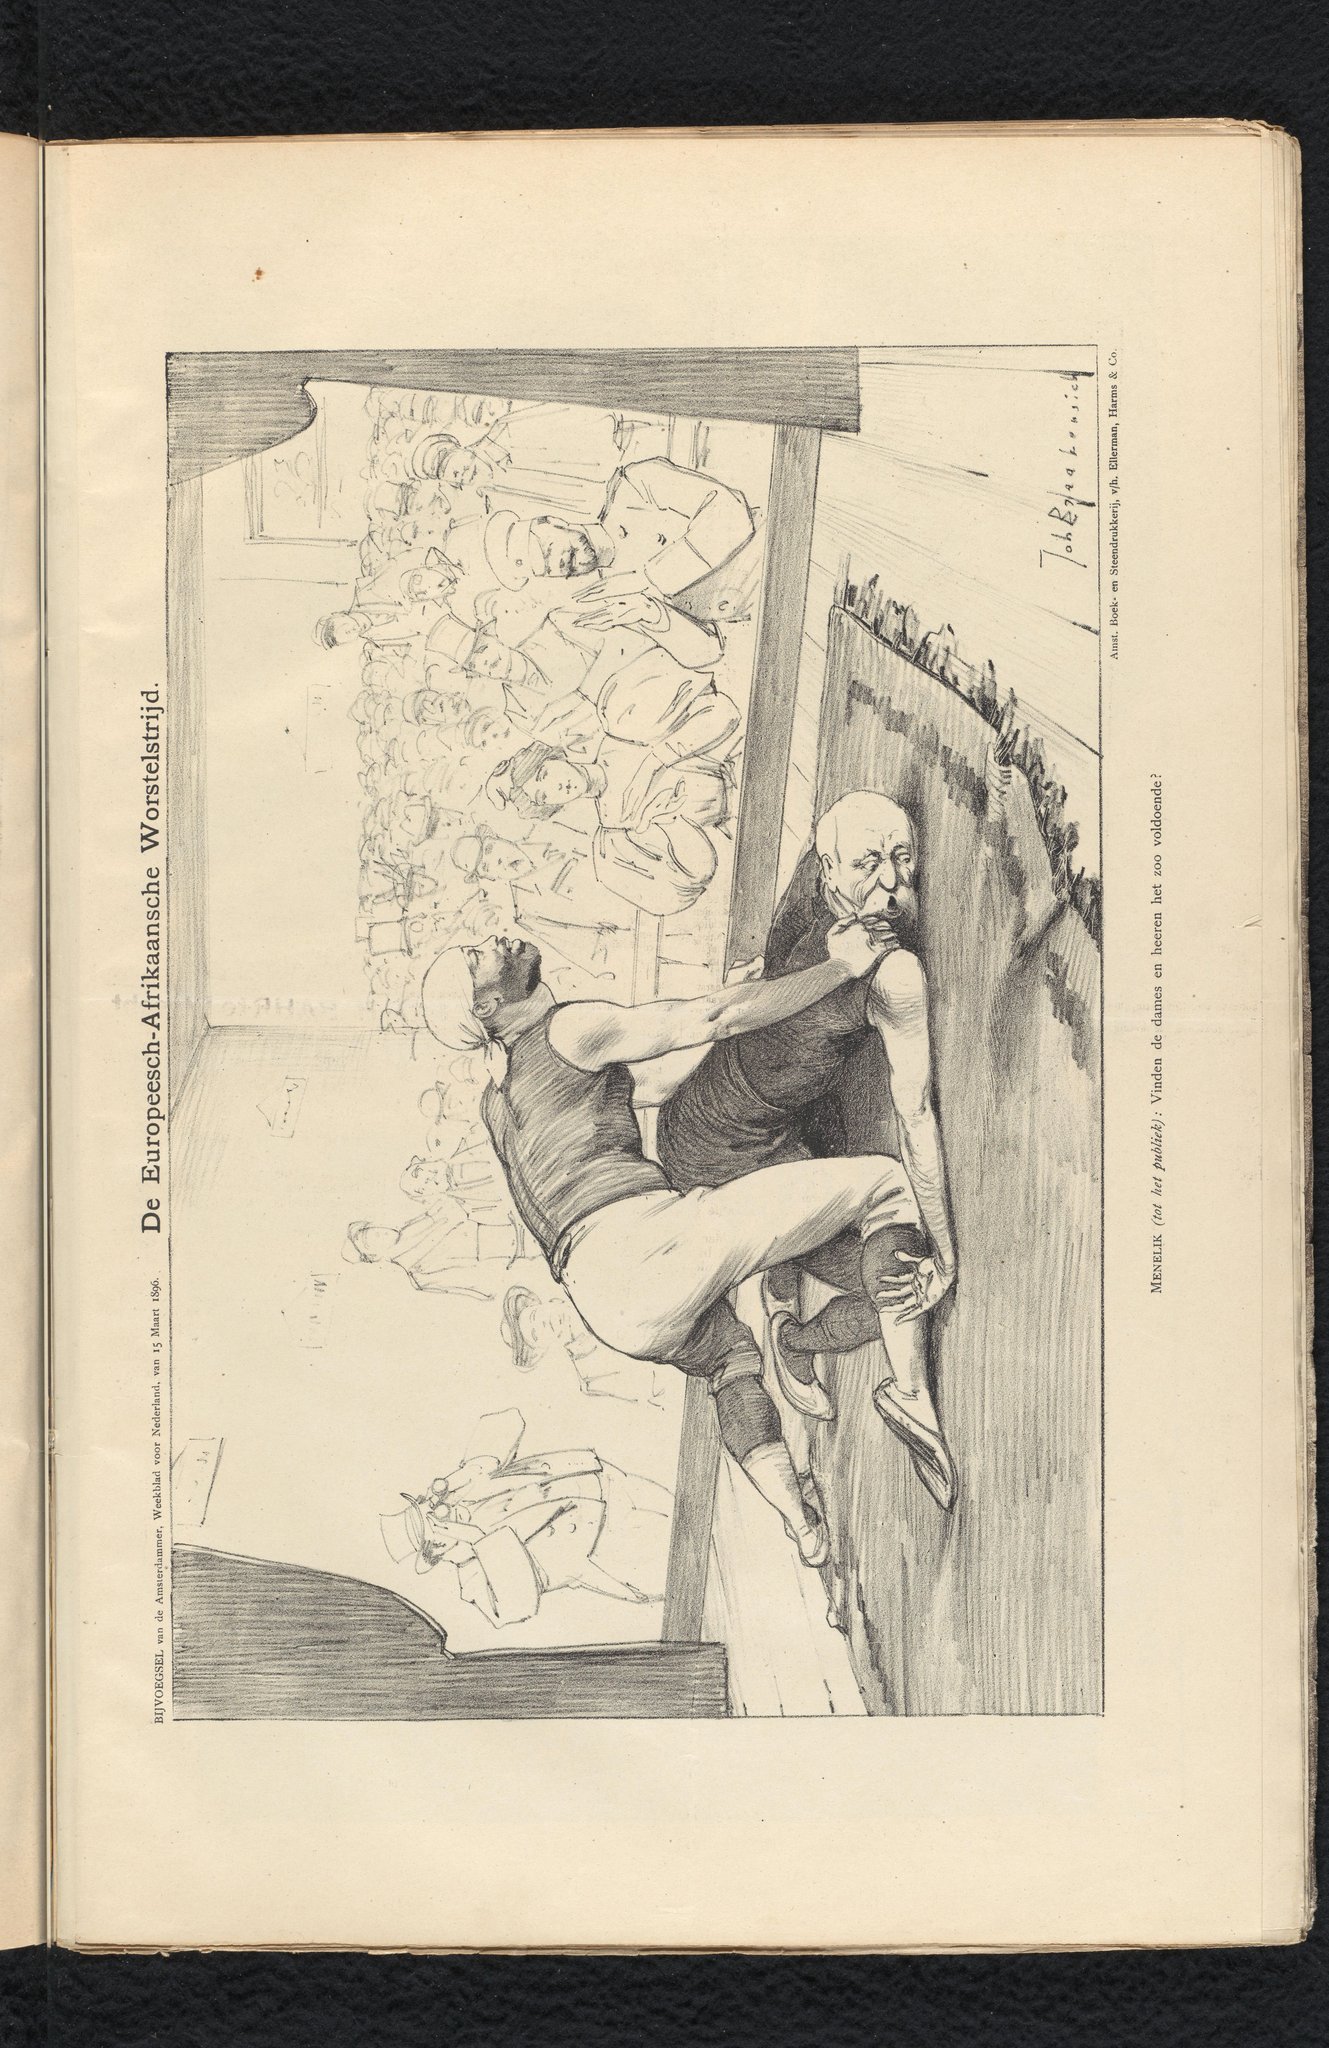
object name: cartoon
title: De Europeesch-Afrikaansche Worstelstrijd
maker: johan braakensiek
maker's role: draughtsman, print maker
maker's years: 1858-1940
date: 1896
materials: paper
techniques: lithograph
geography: amsterdam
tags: personifications of countries, nations, states, districts, etc., wrestling (sport)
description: In een theater met de Europese leiders als publiek verslaat de Ethiopische keizer Menelik II in een worstelwedstrijd zijn Italiaanse tegenstander (Umberto I?), naar aanleiding van de Ethiopische overwinning bij de Slag bij Adwa op 1 maart 1896 tijdens de Eerste Italiaans-Ethiopische Oorlog.